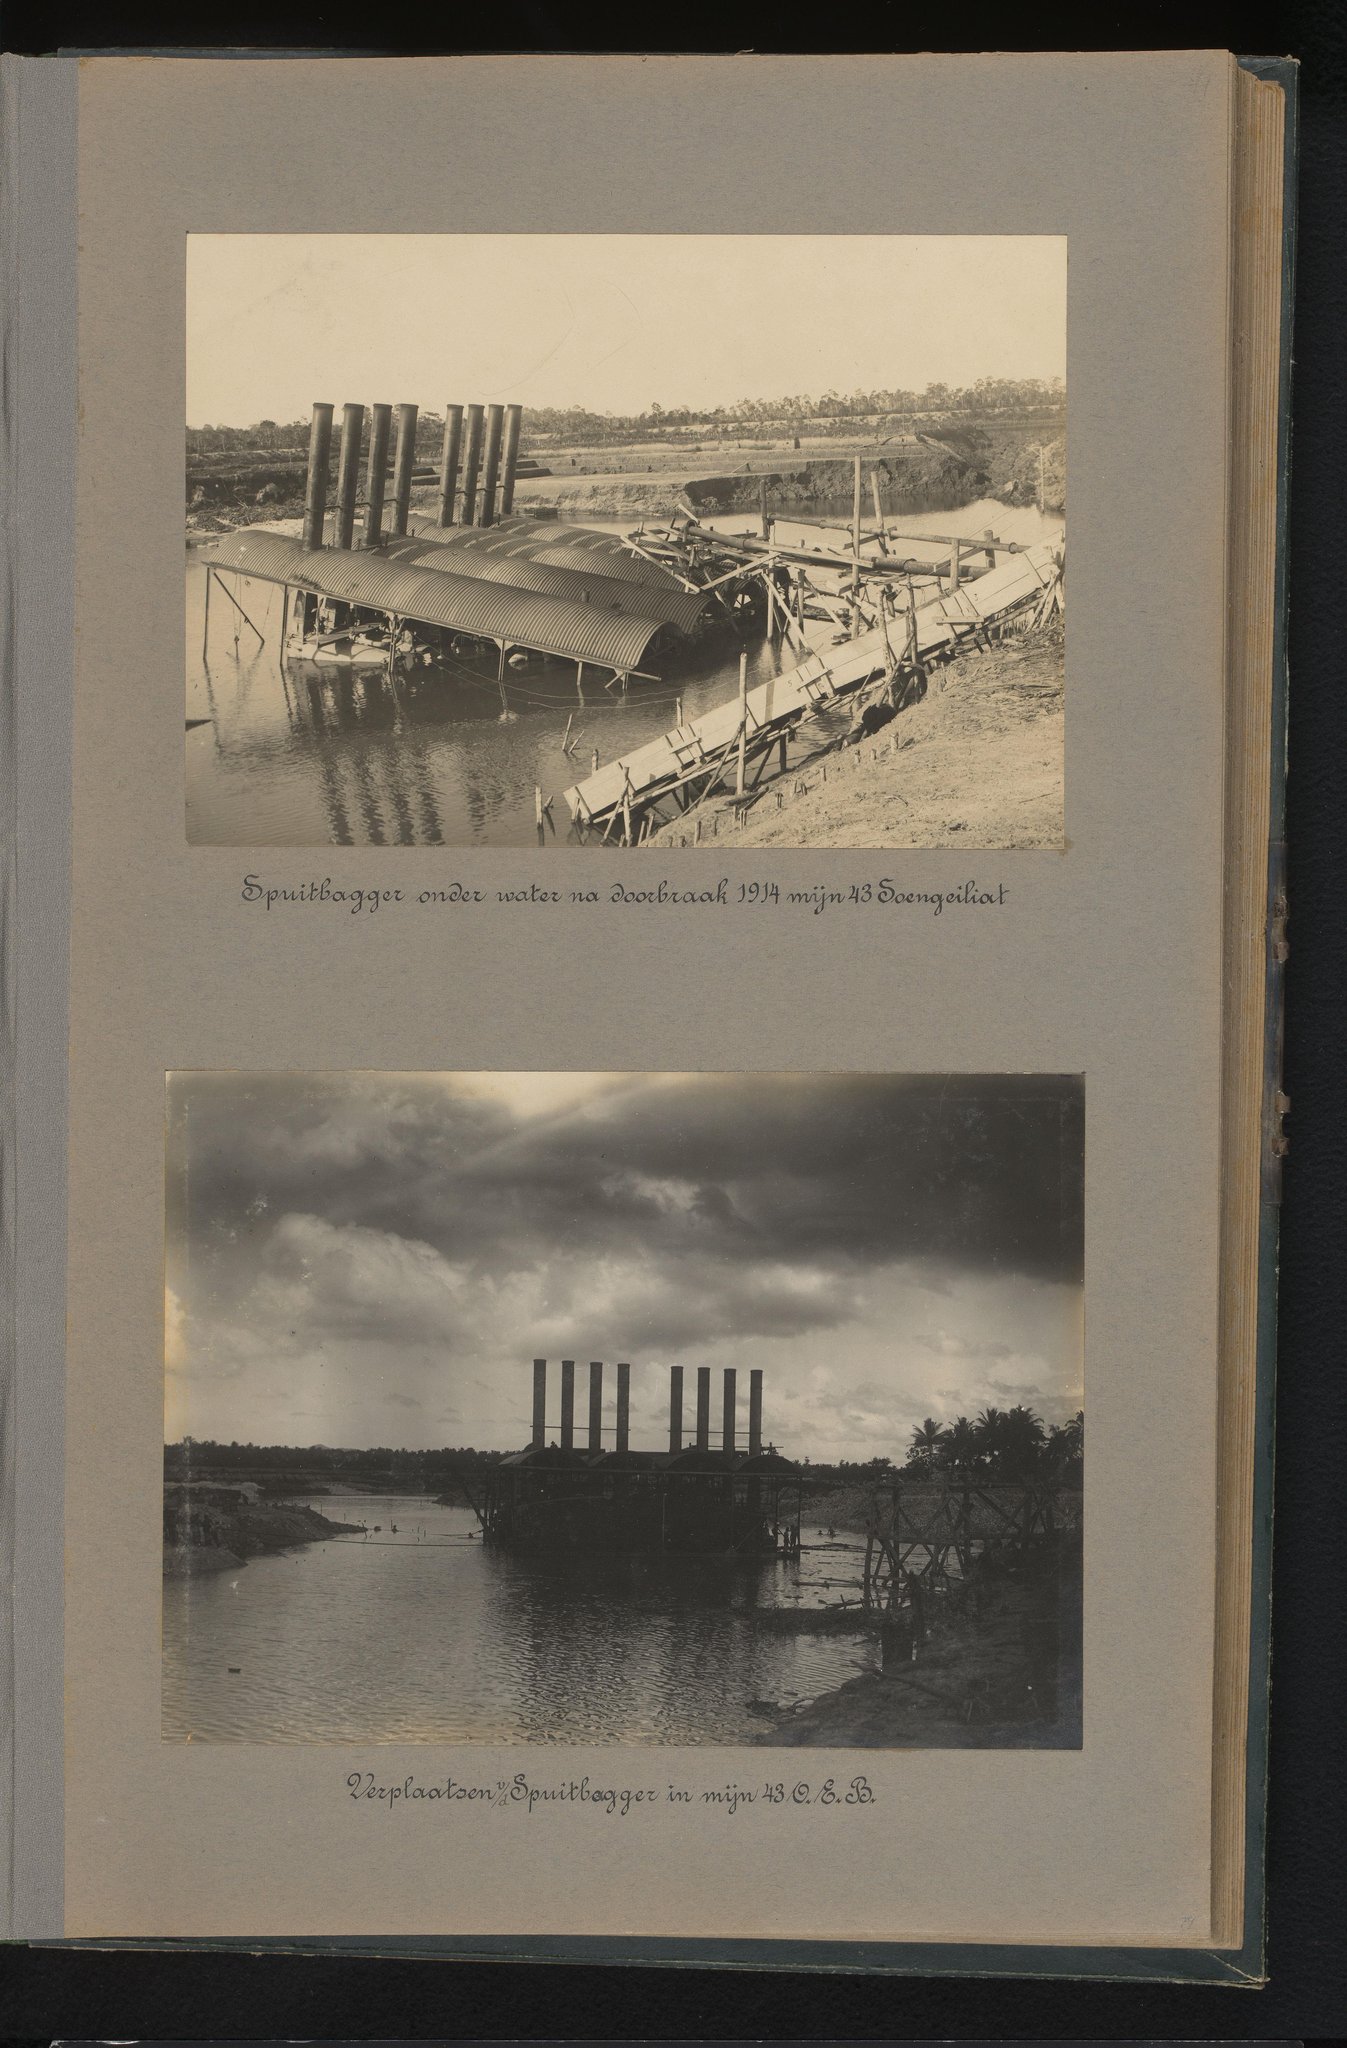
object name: album leaf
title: Gezonken baggermachine na de doorbraak bij een mijn te Soengeiliat in 1914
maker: Anonymous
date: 1914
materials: cardboard, photographic support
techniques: gelatin silver print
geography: bangka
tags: robert julius boers, colonial system, dike-break, mining, dredge, dredging machine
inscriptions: inscription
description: Albumblad met 2 foto's van een gezonken baggerschip na de doorbraak en overstroming in 1914 van een mijn van de Banka-tinwinning te Soengeiliat. Onderdeel van het fotoalbum aangeboden aan Robert Julius Boers bij zijn vertrek naar Nederland in 1919 door het personeel van de Banka-tinwinning.